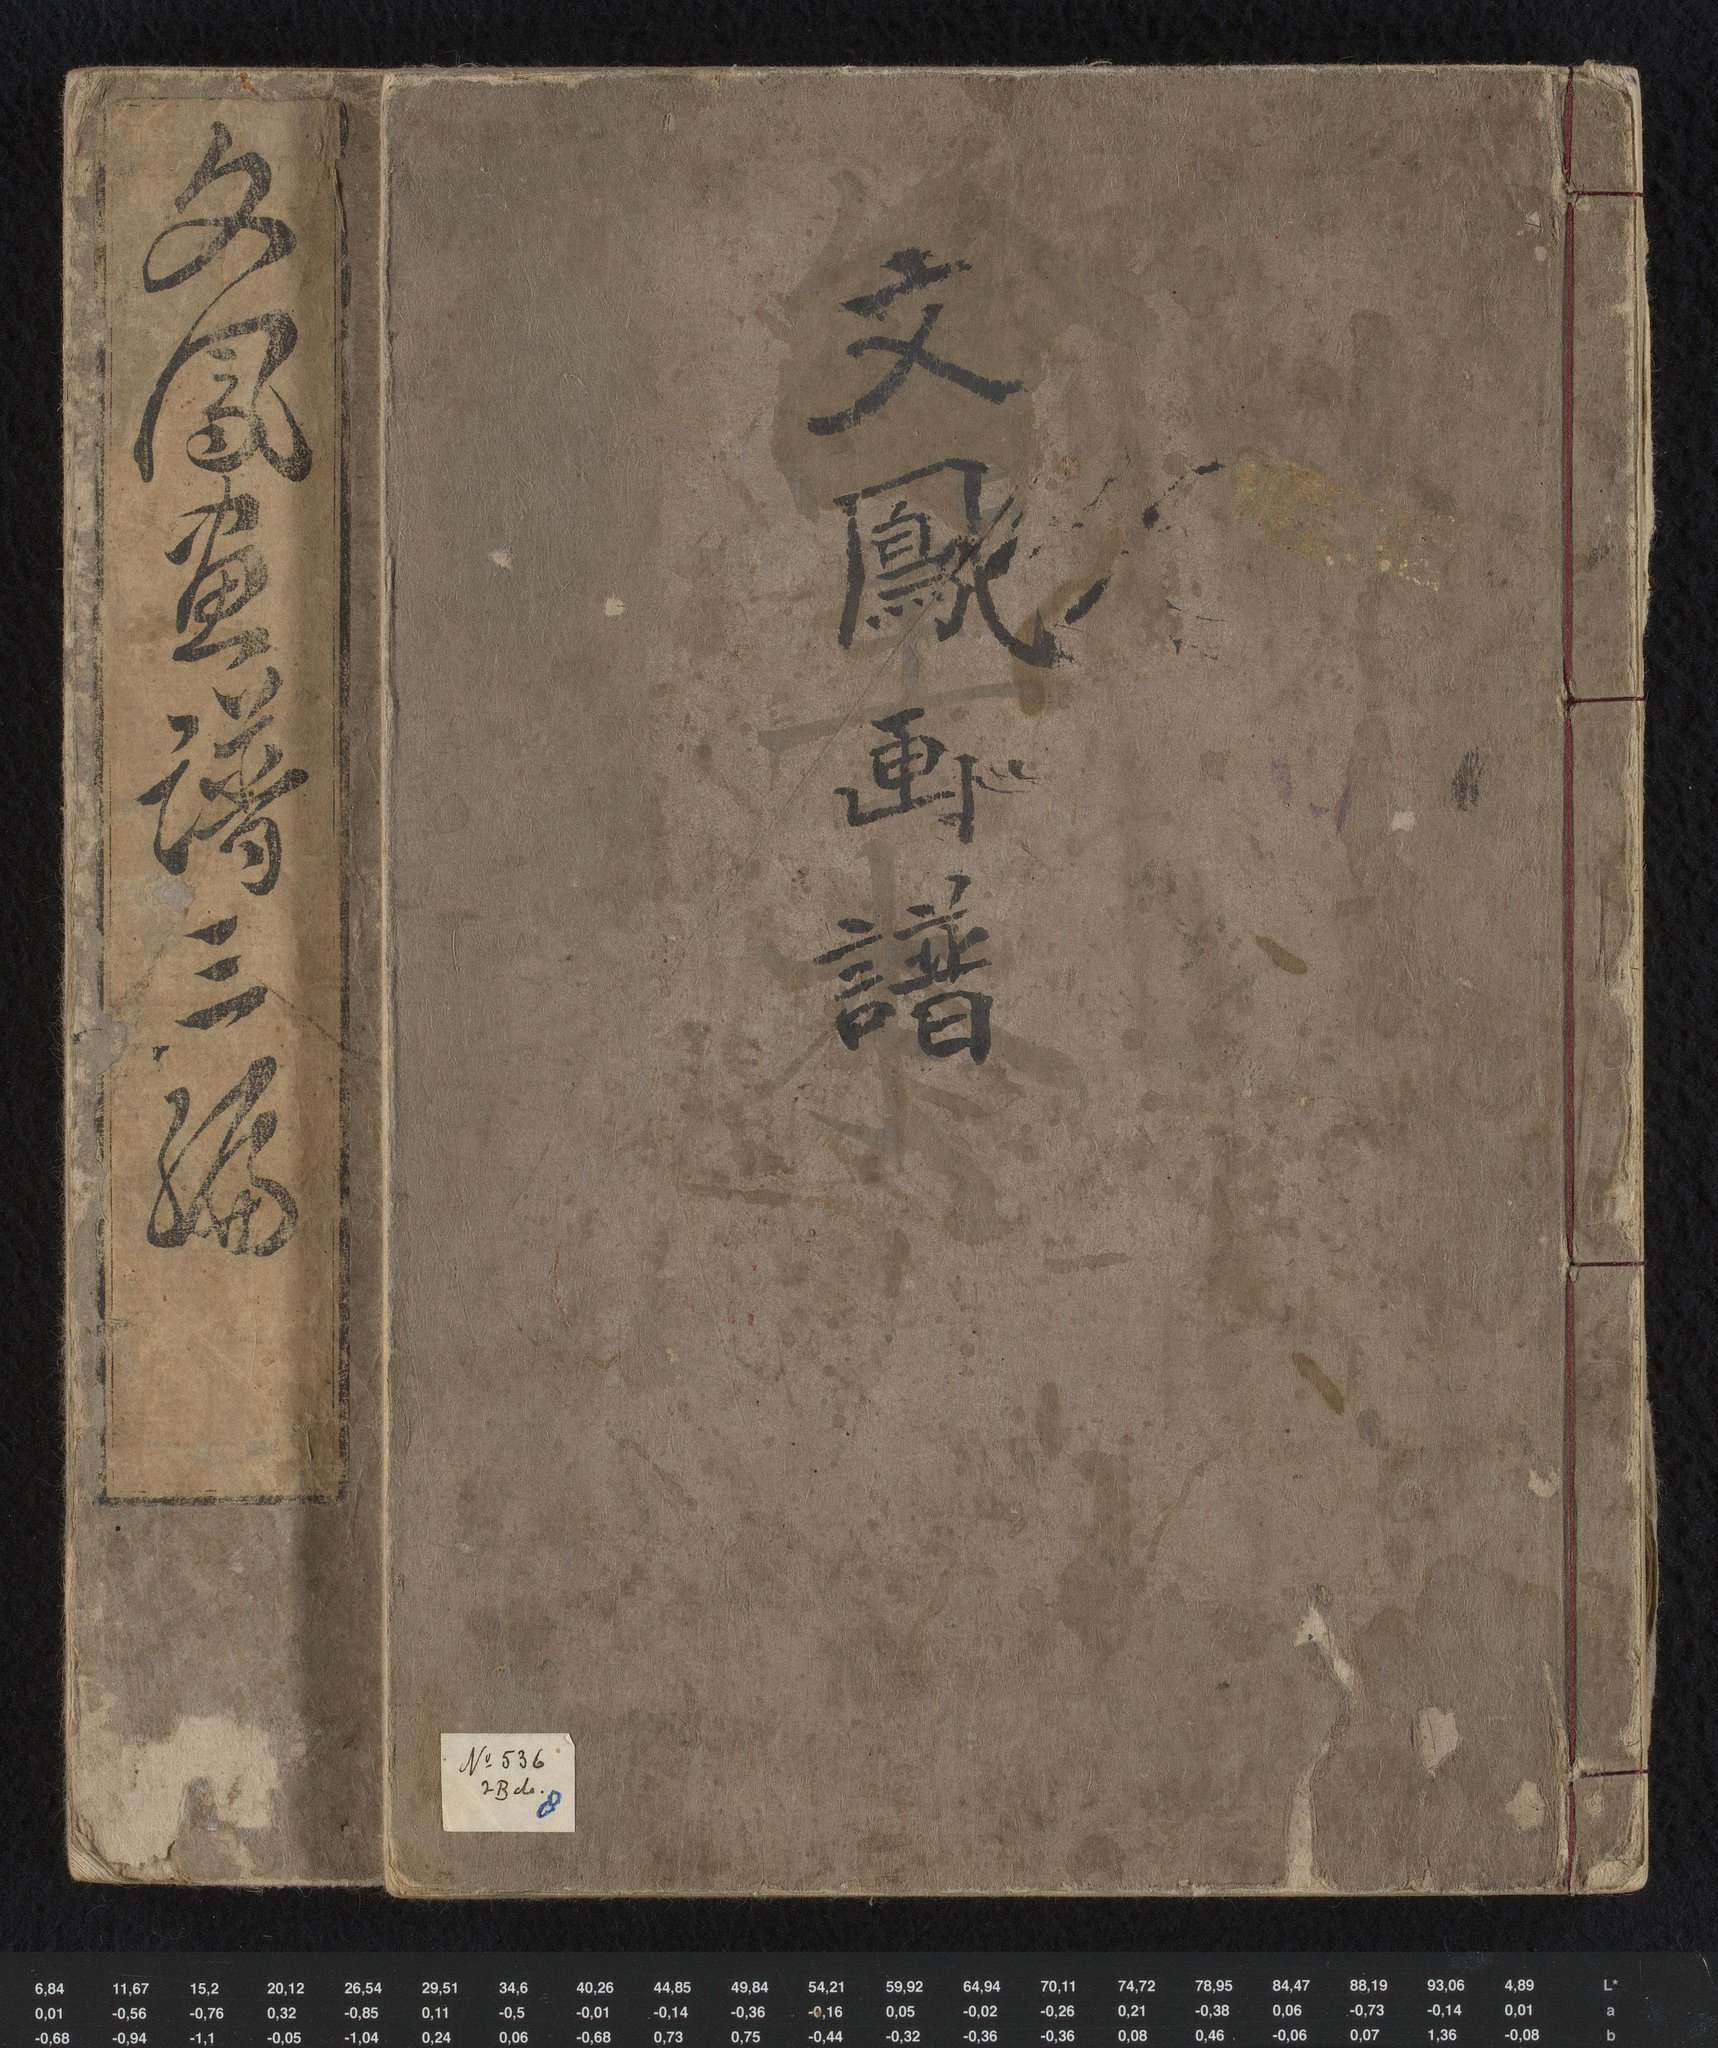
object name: book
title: Schetsen van Bunpo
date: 1811-1813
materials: paper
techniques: woodcut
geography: japan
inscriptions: collector's mark: Lugt 2228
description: Twee delen (van drie) met afbeeldingen van mensen, dieren en landschappen.